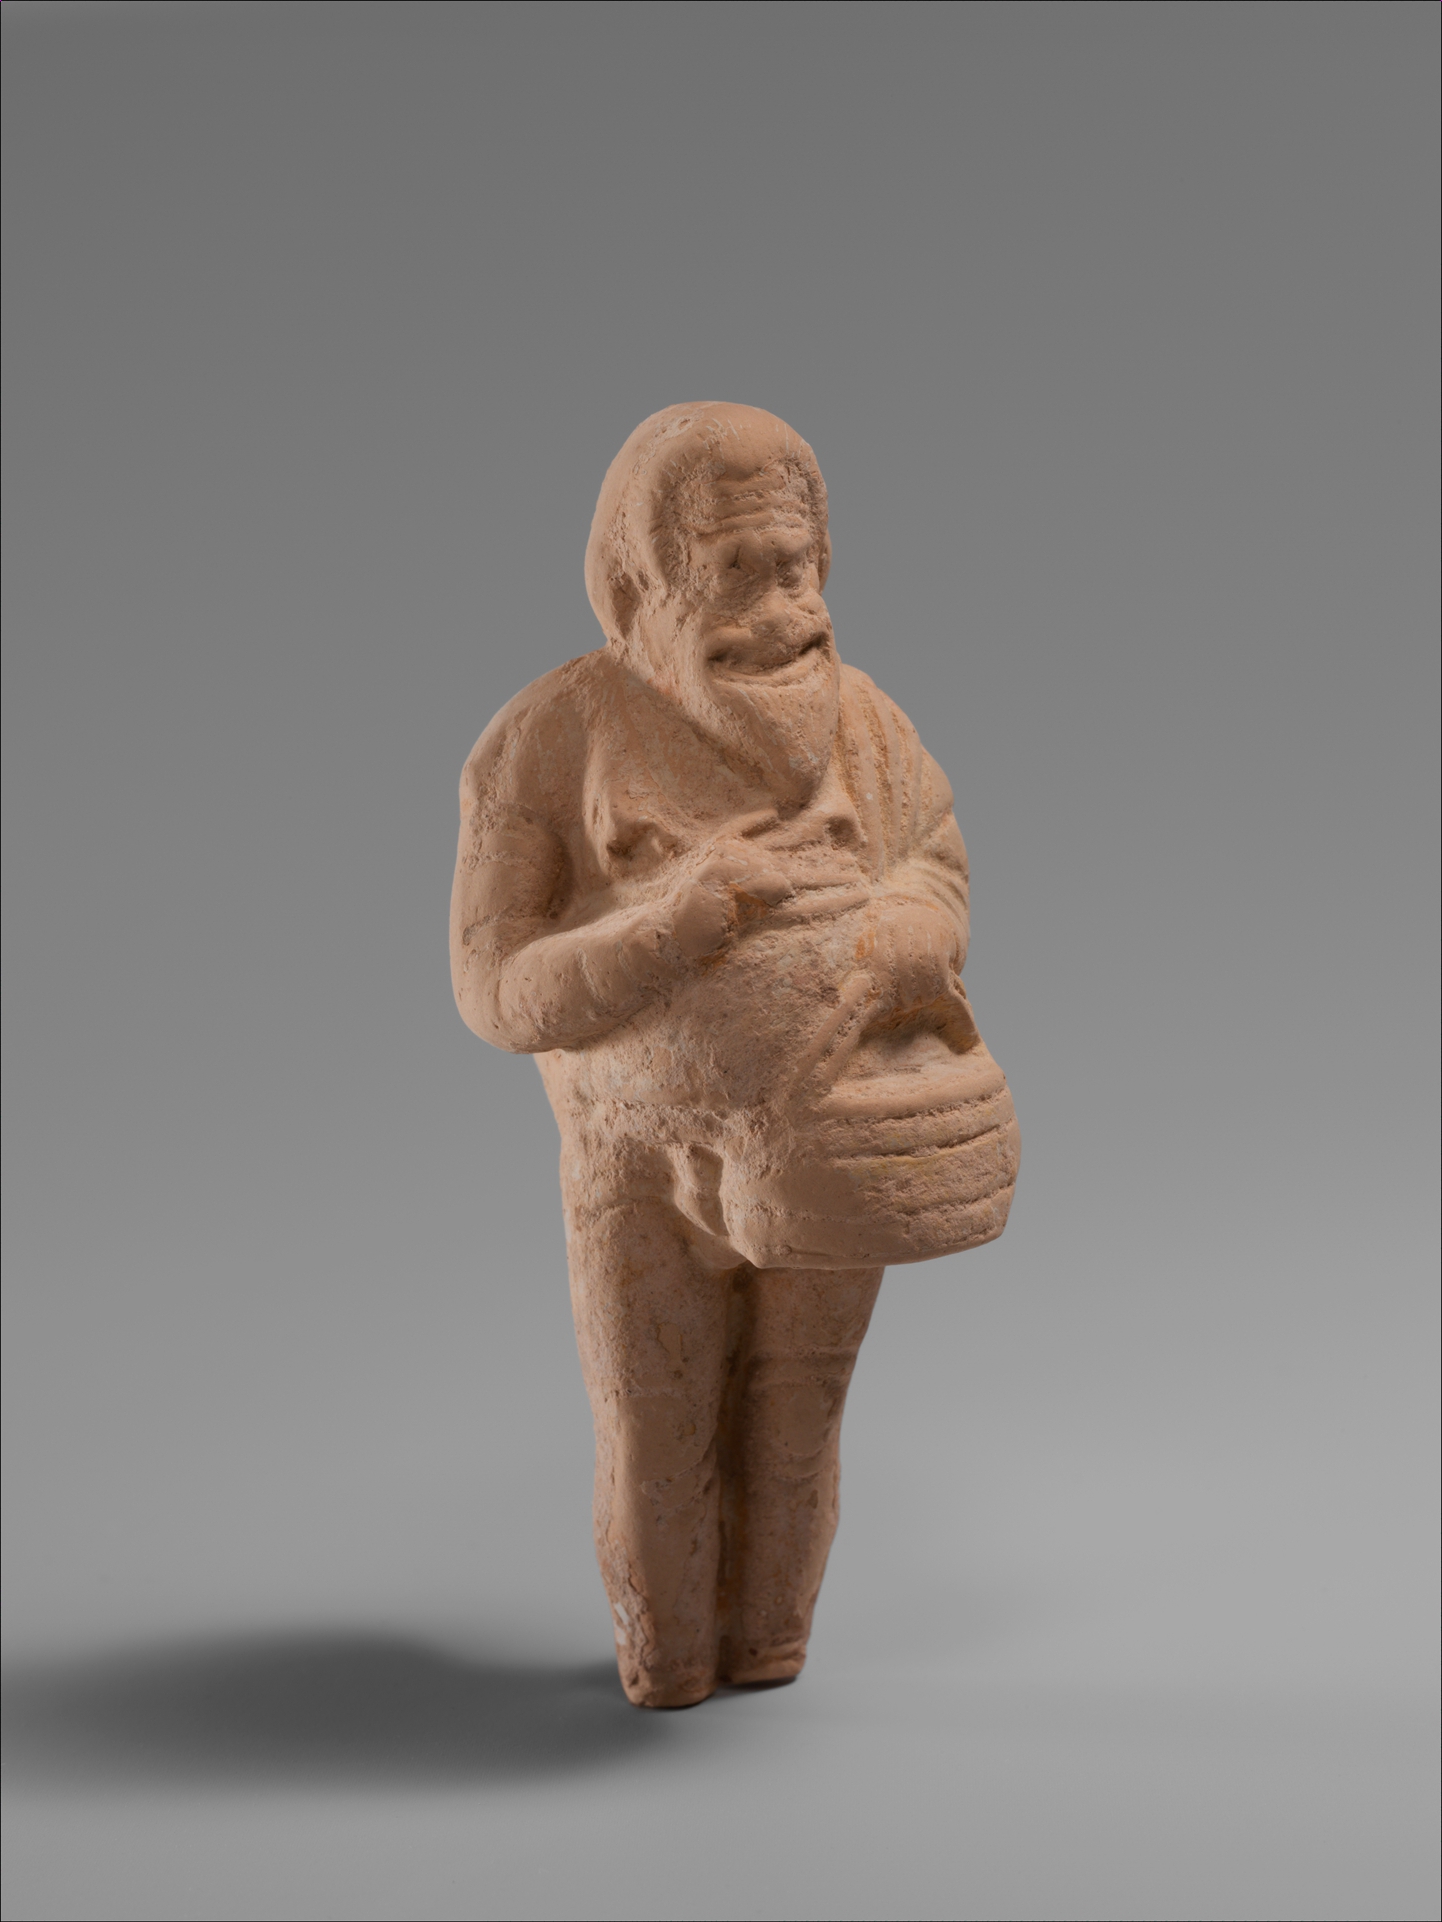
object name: statuette of an actor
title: Terracotta statuette of an actor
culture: greek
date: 434-368 BCE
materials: terracotta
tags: men,actors